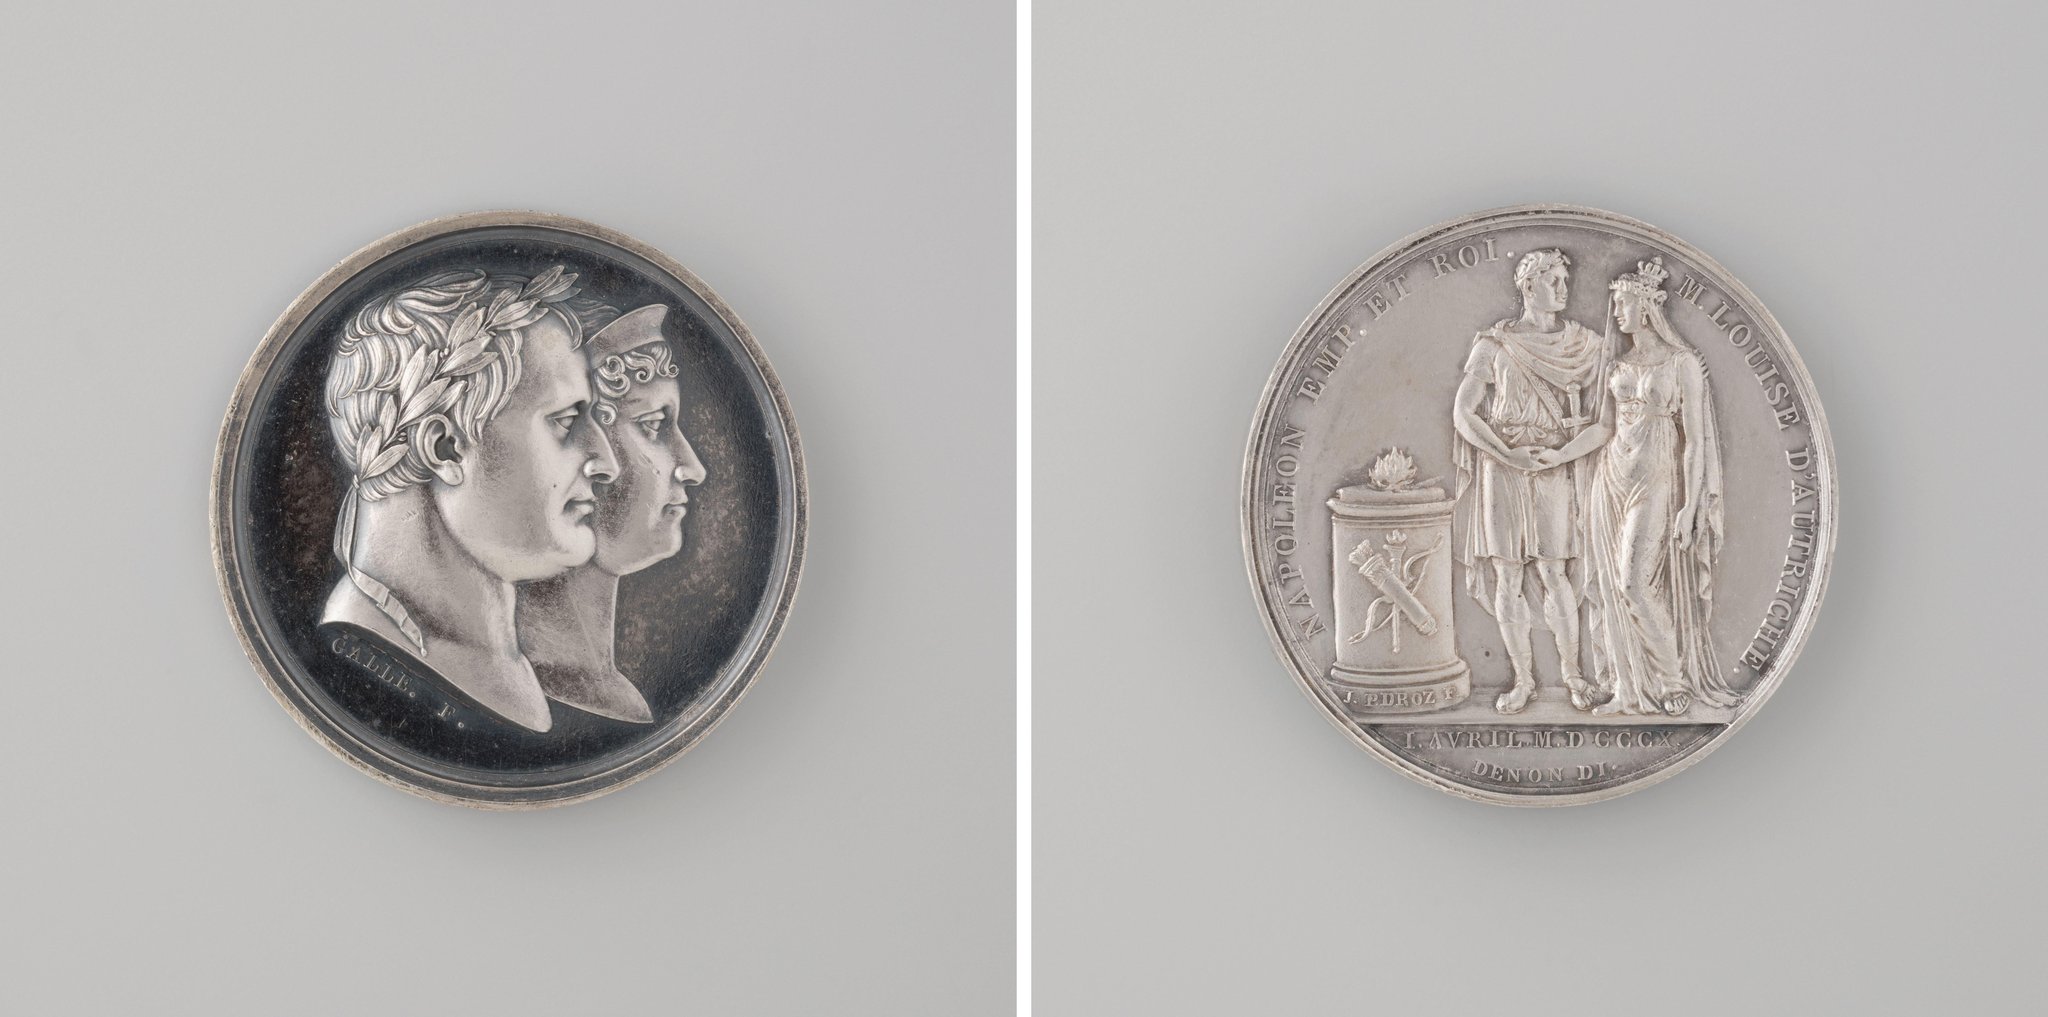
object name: history medal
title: Huwelijk van Napoleon I Bonaparte, keizer der Fransen met Marie Louise, aartshertogin van Oostenrijk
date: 1810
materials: silver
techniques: striking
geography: paris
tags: napoleon i (emperor of the french), vienna, marie louise van oostenrijk (keizerin der fransen), paris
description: Zilveren penning. Voorzijde: borststuk man met lauwerkrans en vrouw met diadeem binnen omschrift. Keerzijde: man in Romeinse kledij met lauwerkrans en vrouw met kroon geven elkaar hand staande voor brandend altaar, waarvan basis is versierd met boog, pijlenkoker en brandende fakkel binnen omschrift; afsnede: datering